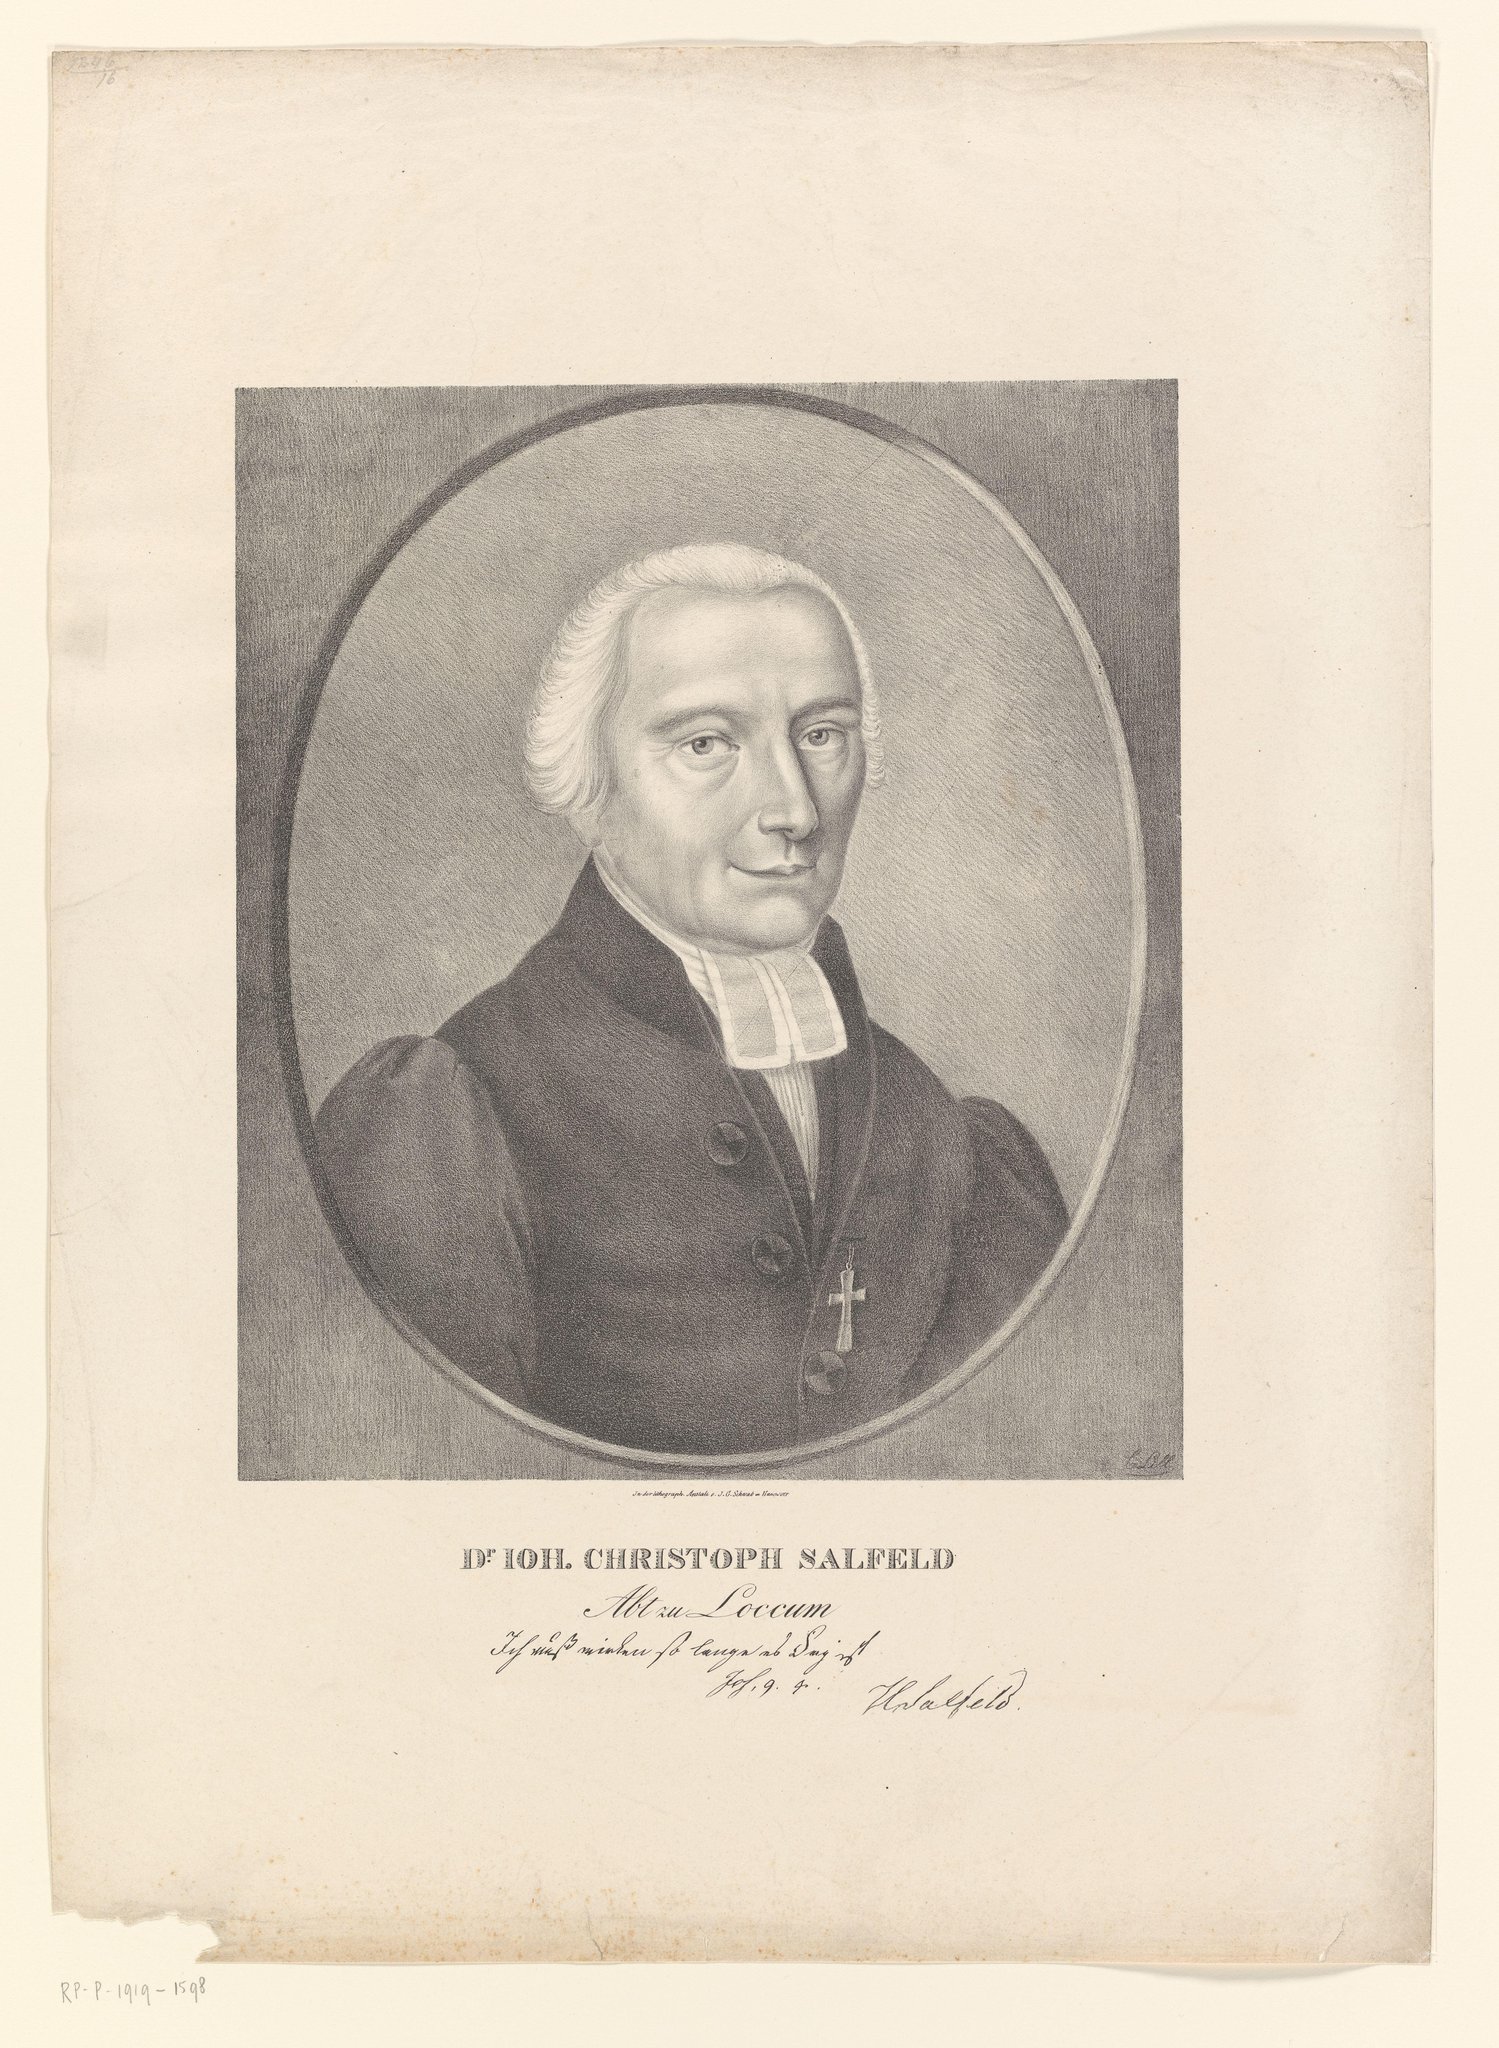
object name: print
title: Dr. Joh. Christoph Salfeld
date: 1817-1879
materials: paper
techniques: lithograph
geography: hannover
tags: adult man, historical persons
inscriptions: collector's mark: Lugt 2228